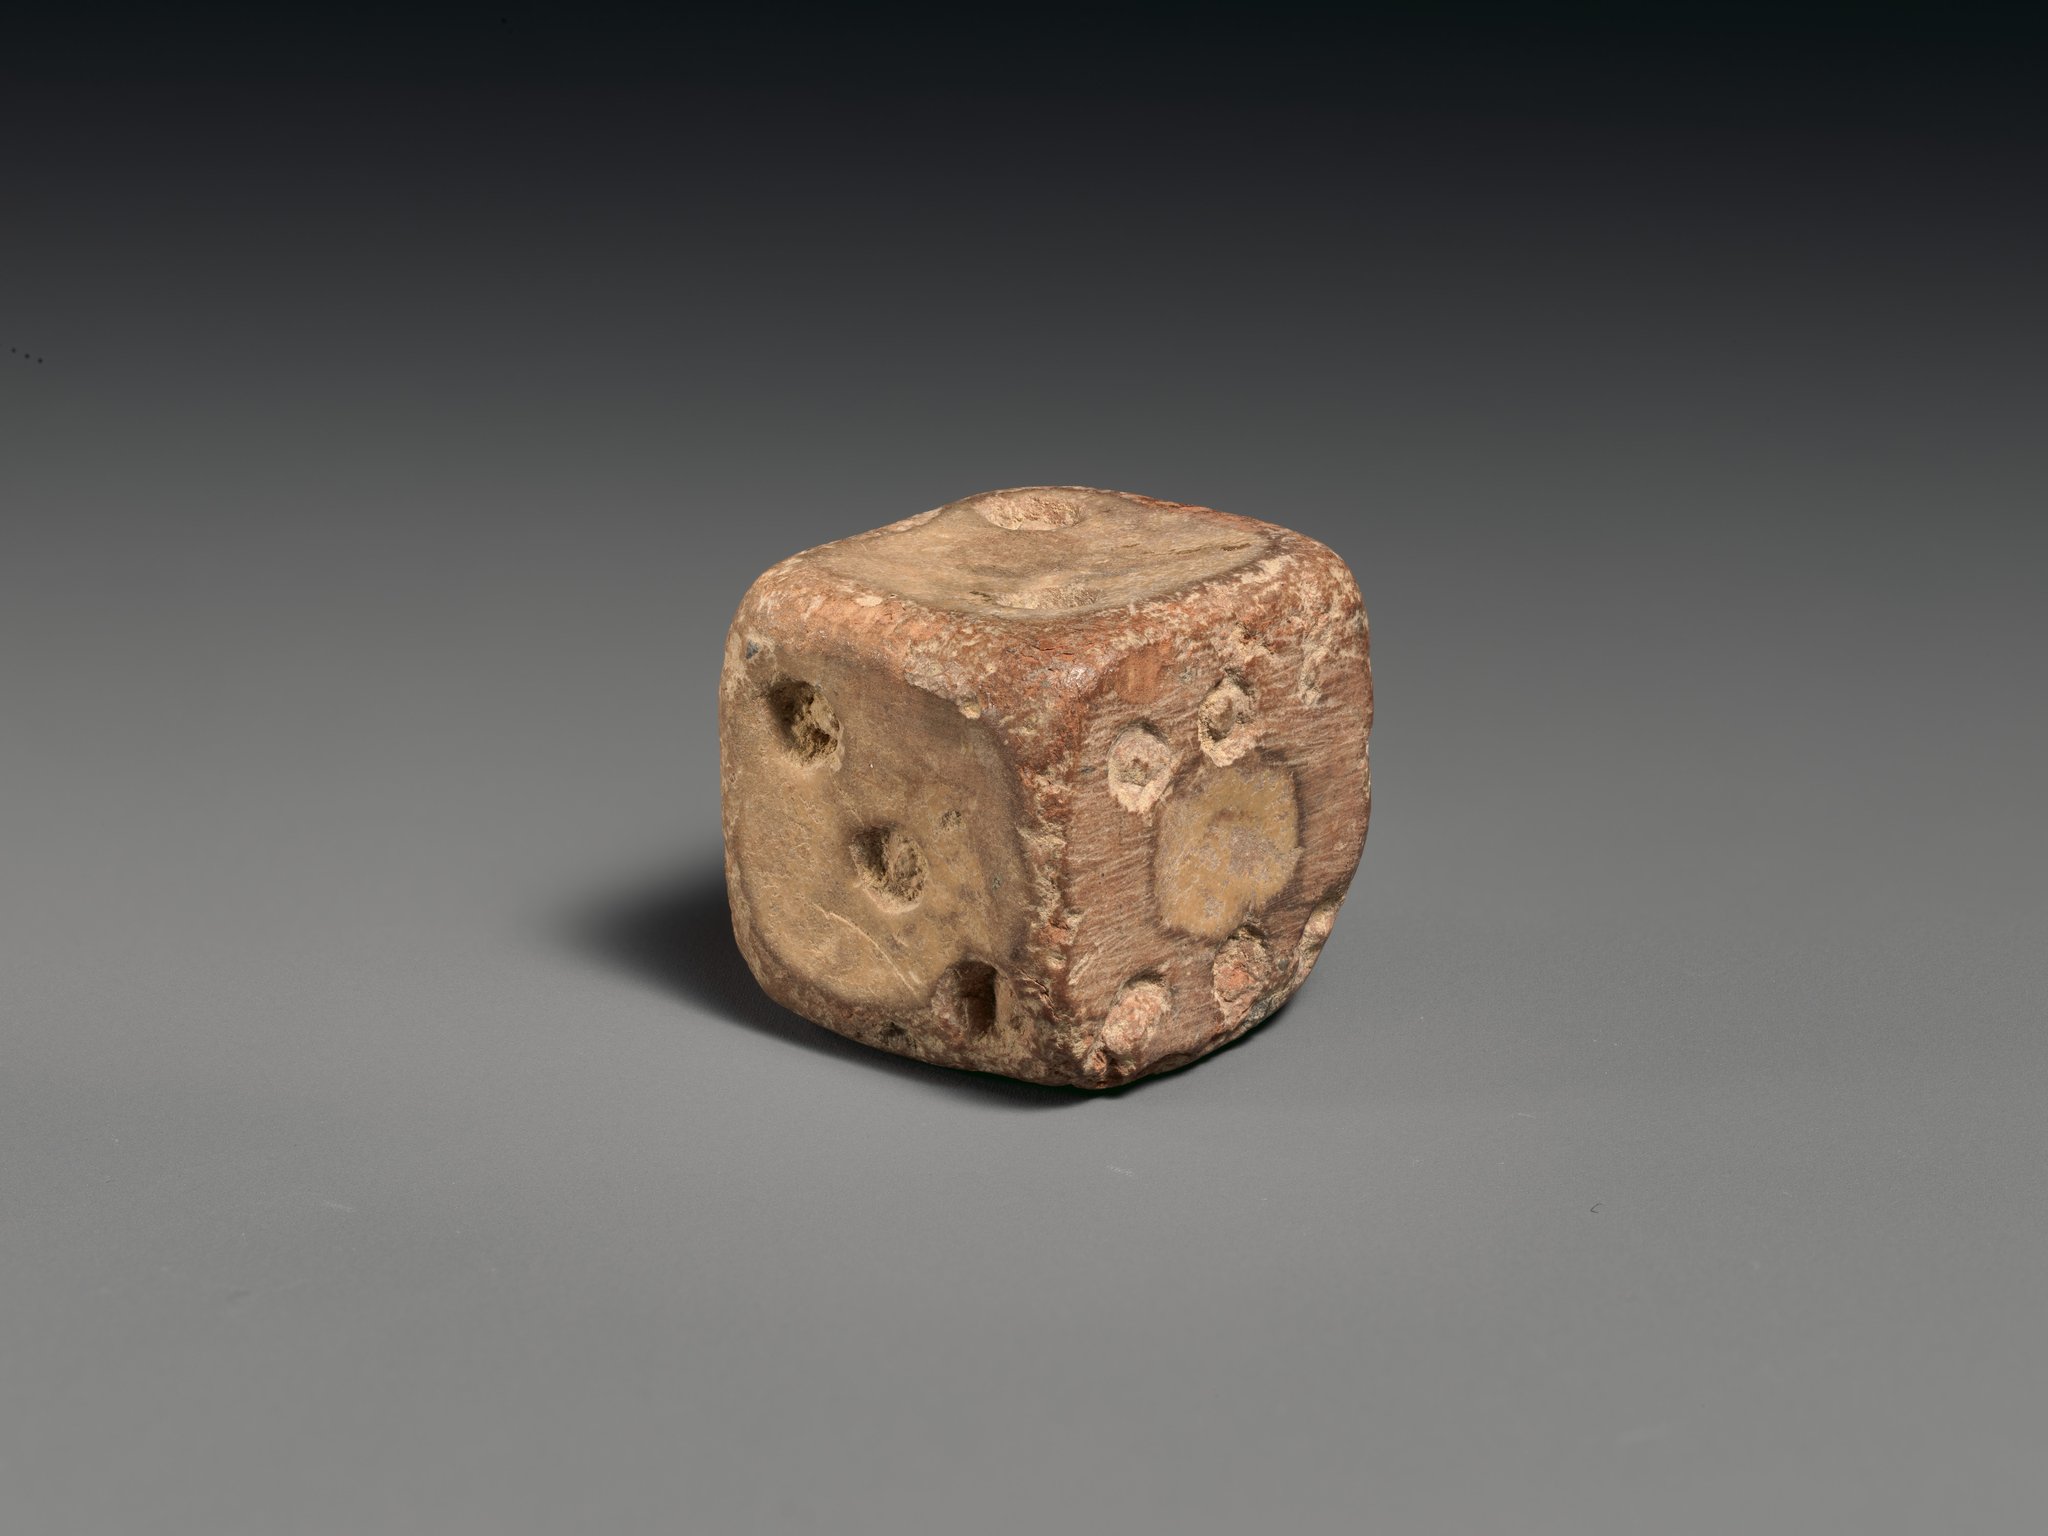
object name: die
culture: sasanian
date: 201-700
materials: ceramic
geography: iran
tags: dice